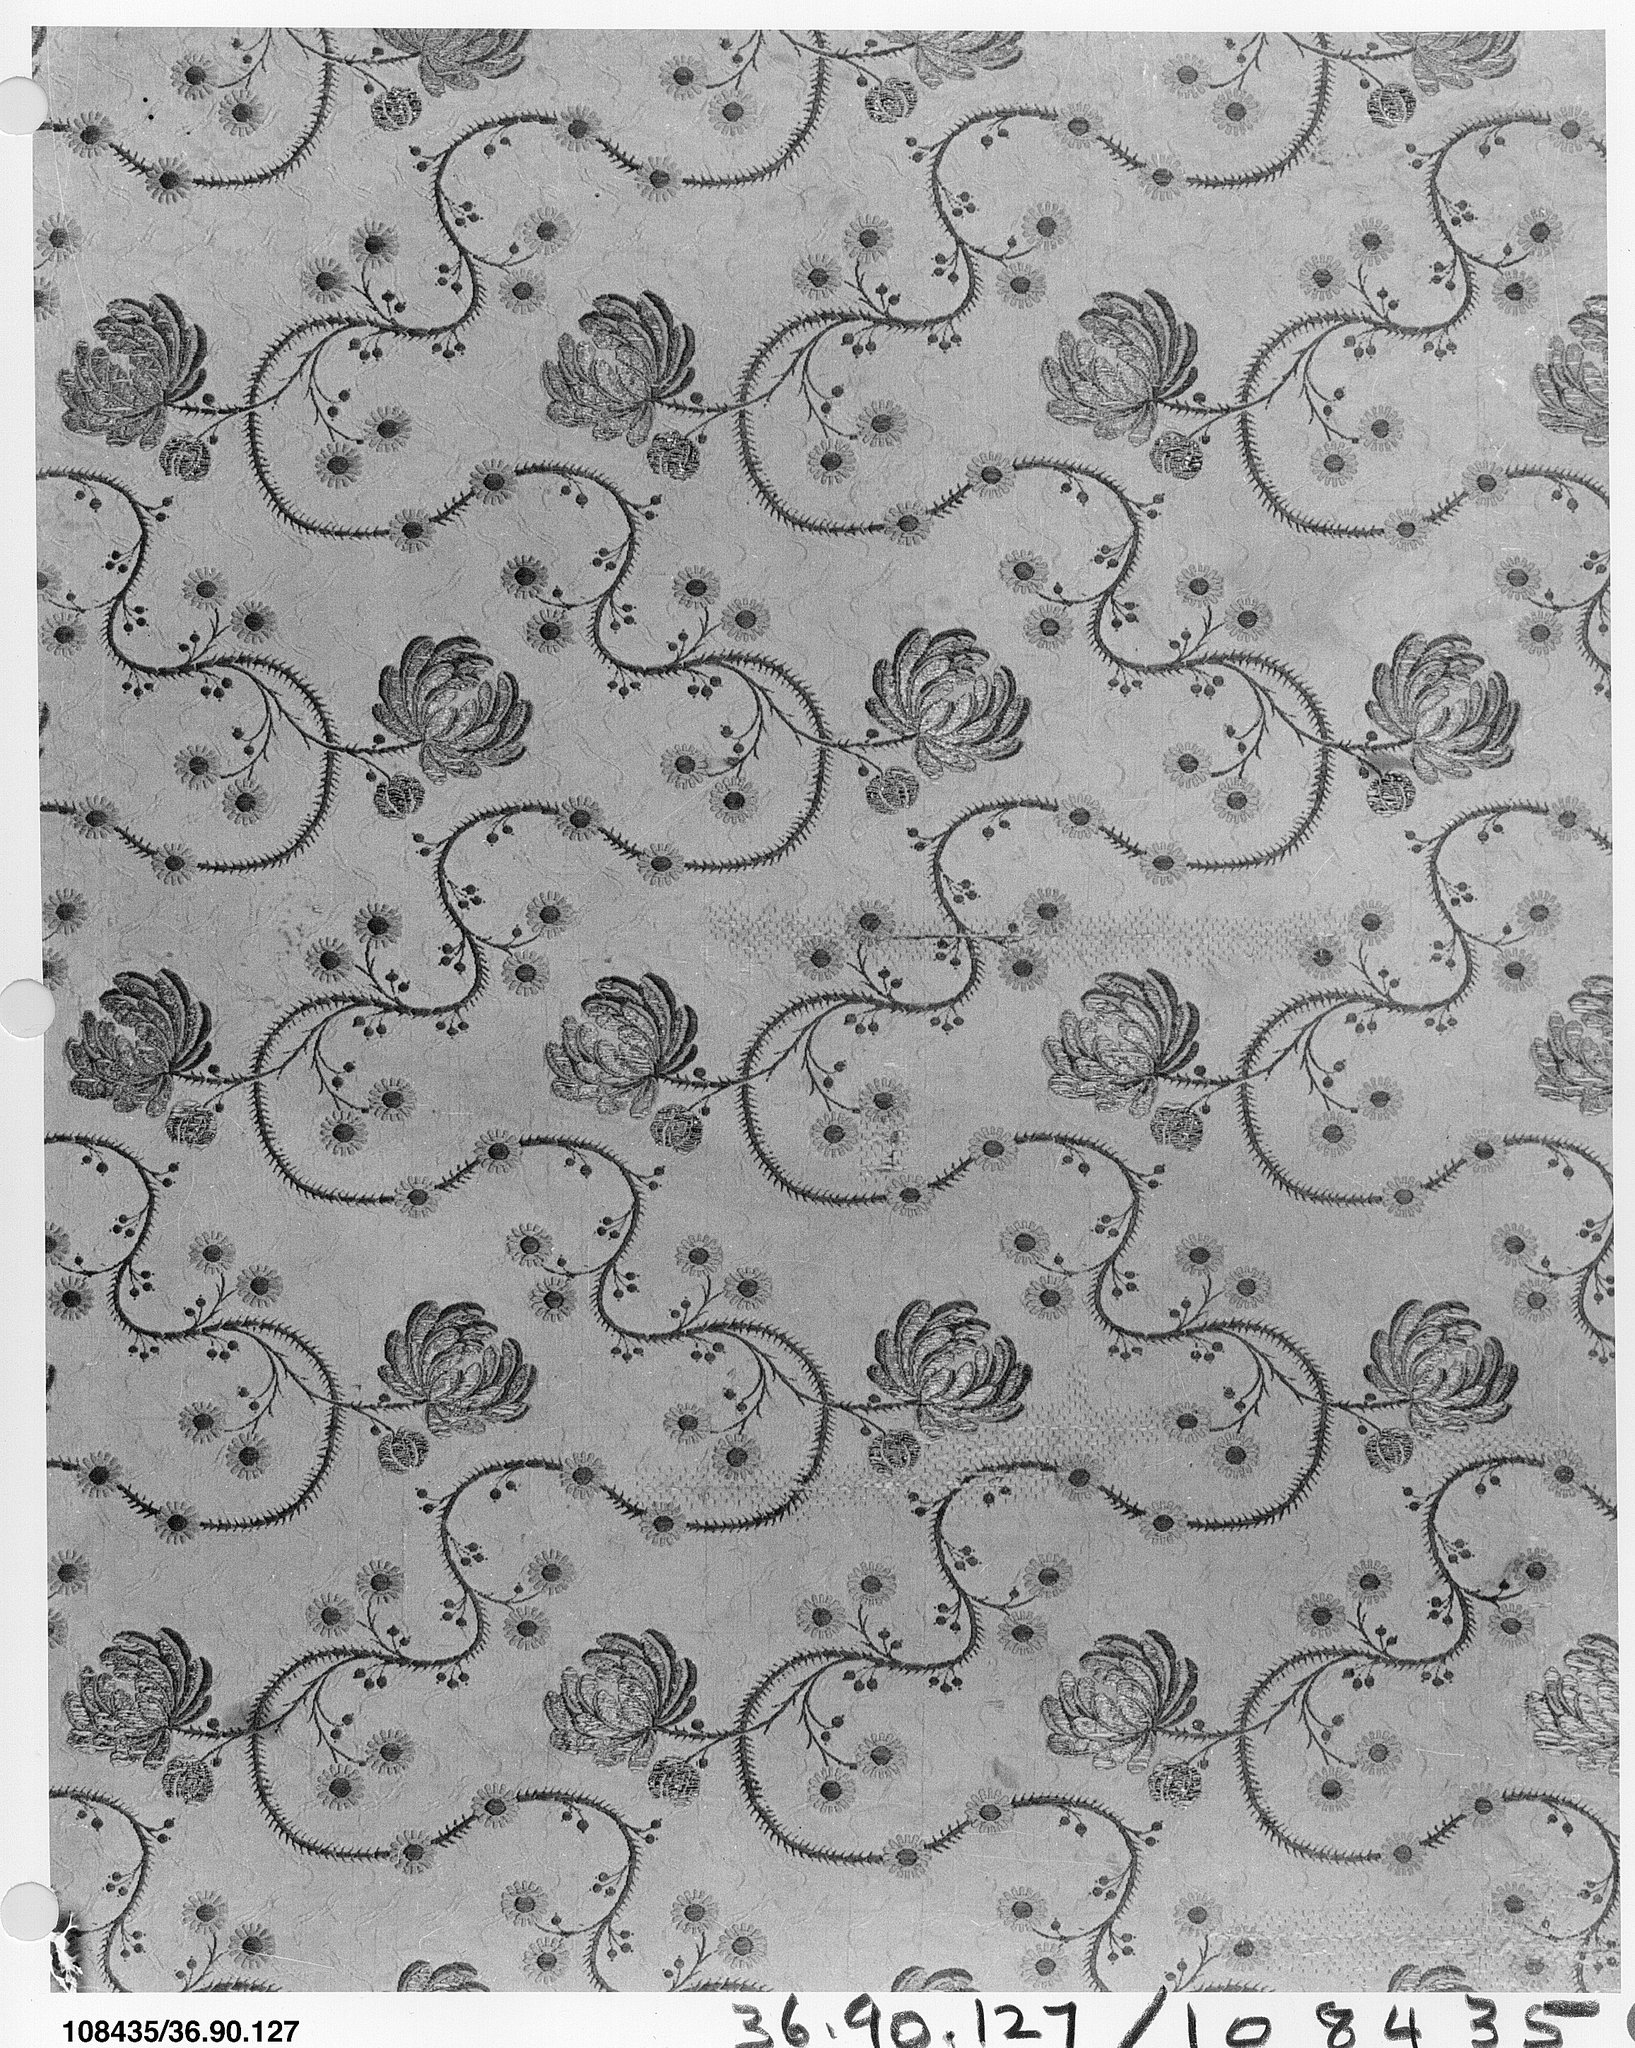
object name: piece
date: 1750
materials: metal thread, silk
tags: flowers